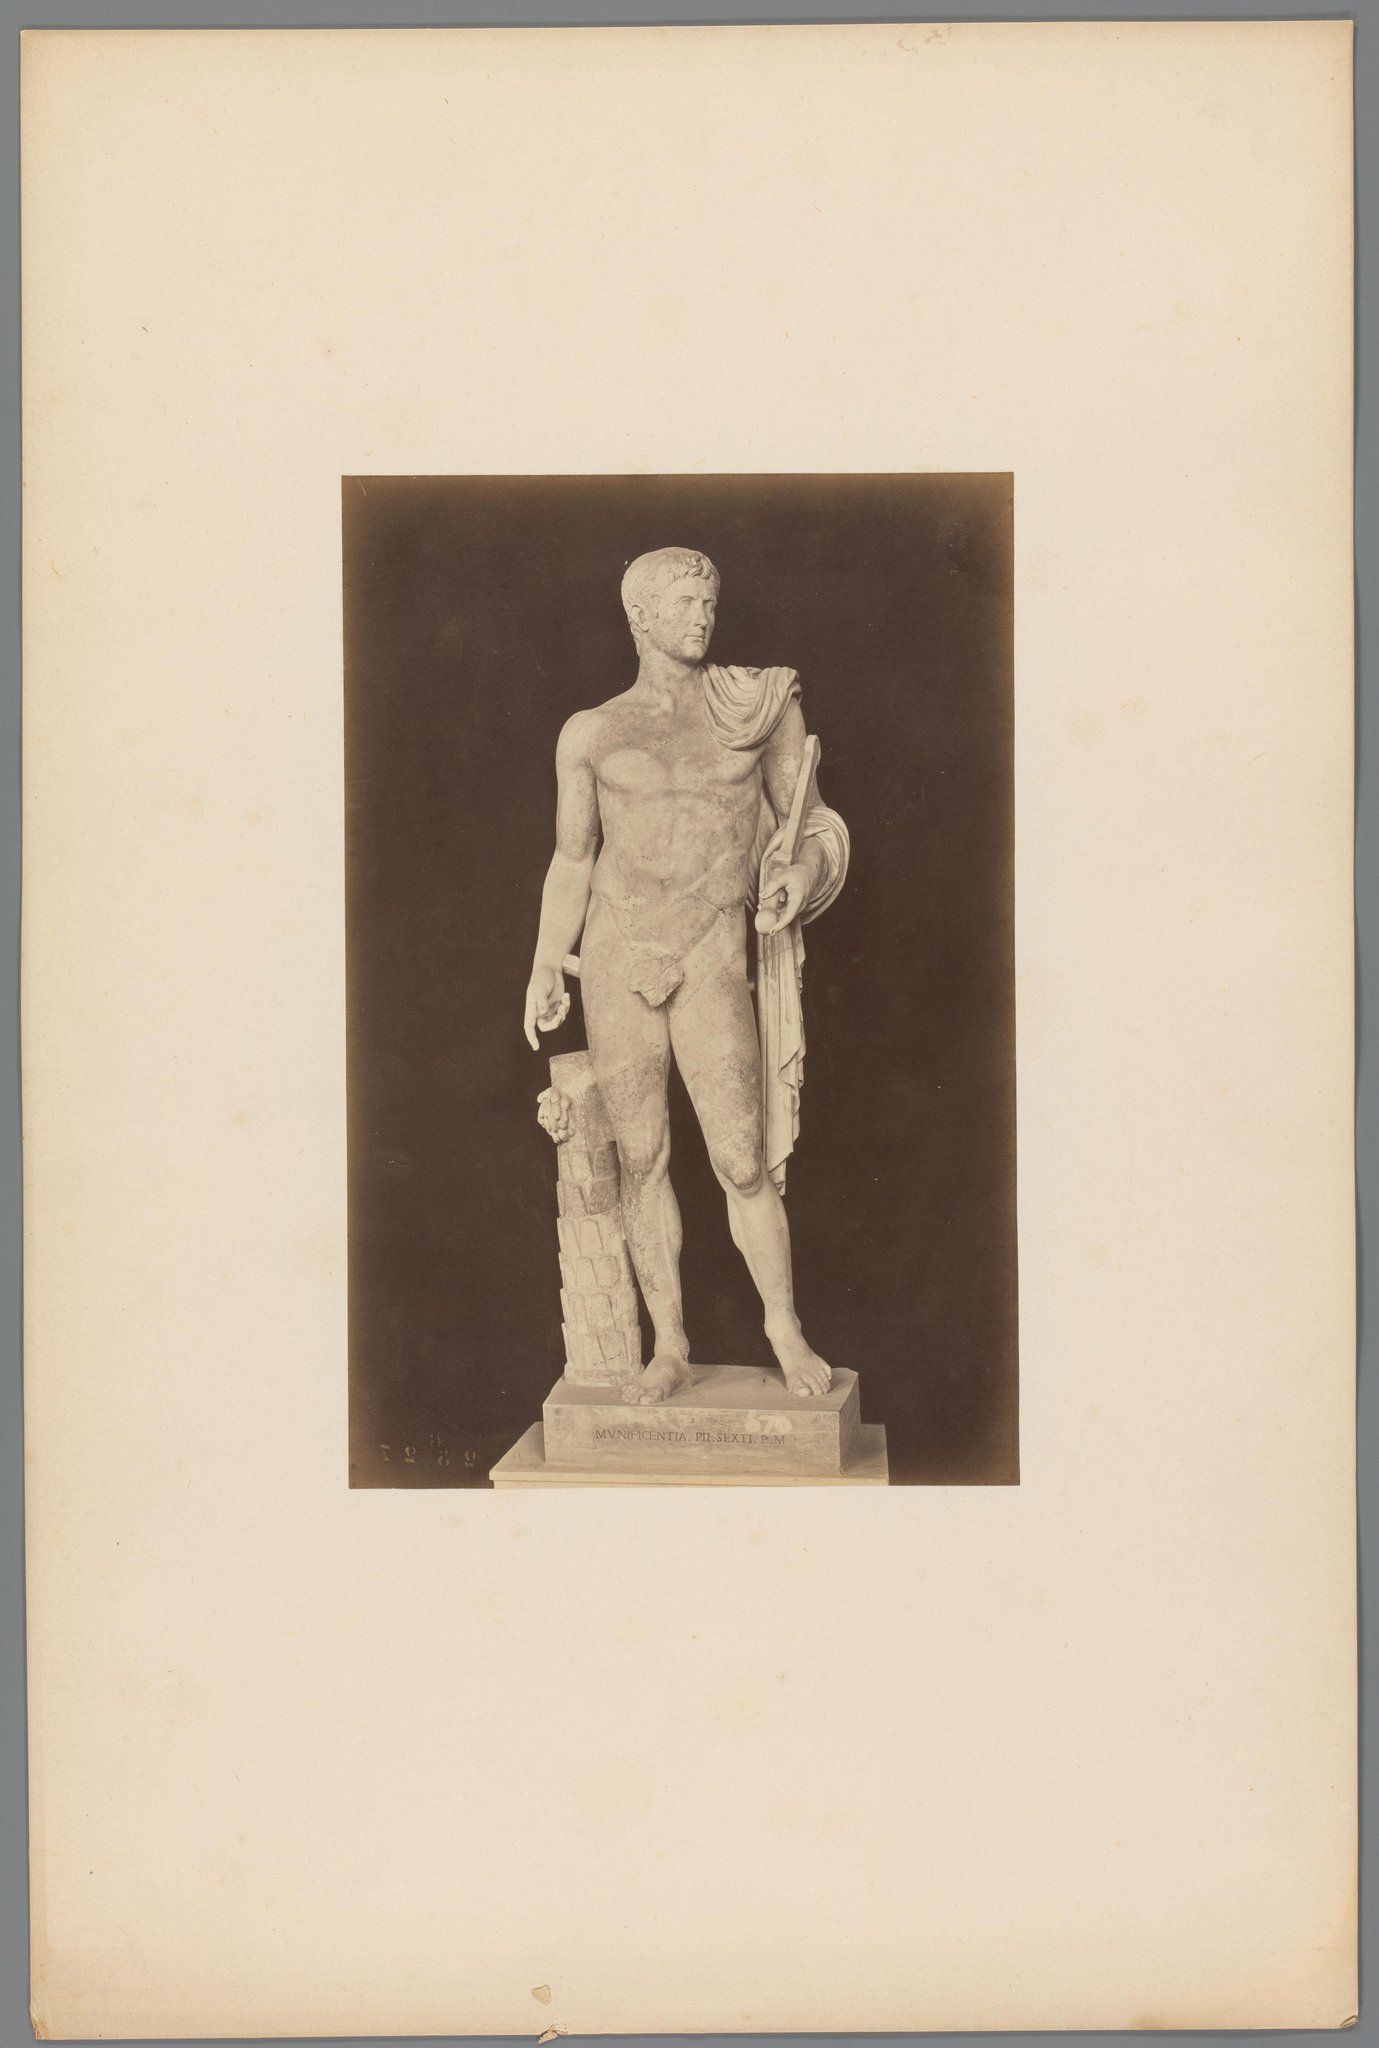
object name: photograph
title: Sculptuur van een man in de Vaticaanse Musea, Italië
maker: Anonymous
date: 1851-1900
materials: cardboard, paper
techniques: albumen print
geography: vatican city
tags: piece of sculpture, reproduction of a piece of sculpture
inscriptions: number: ‘2527’